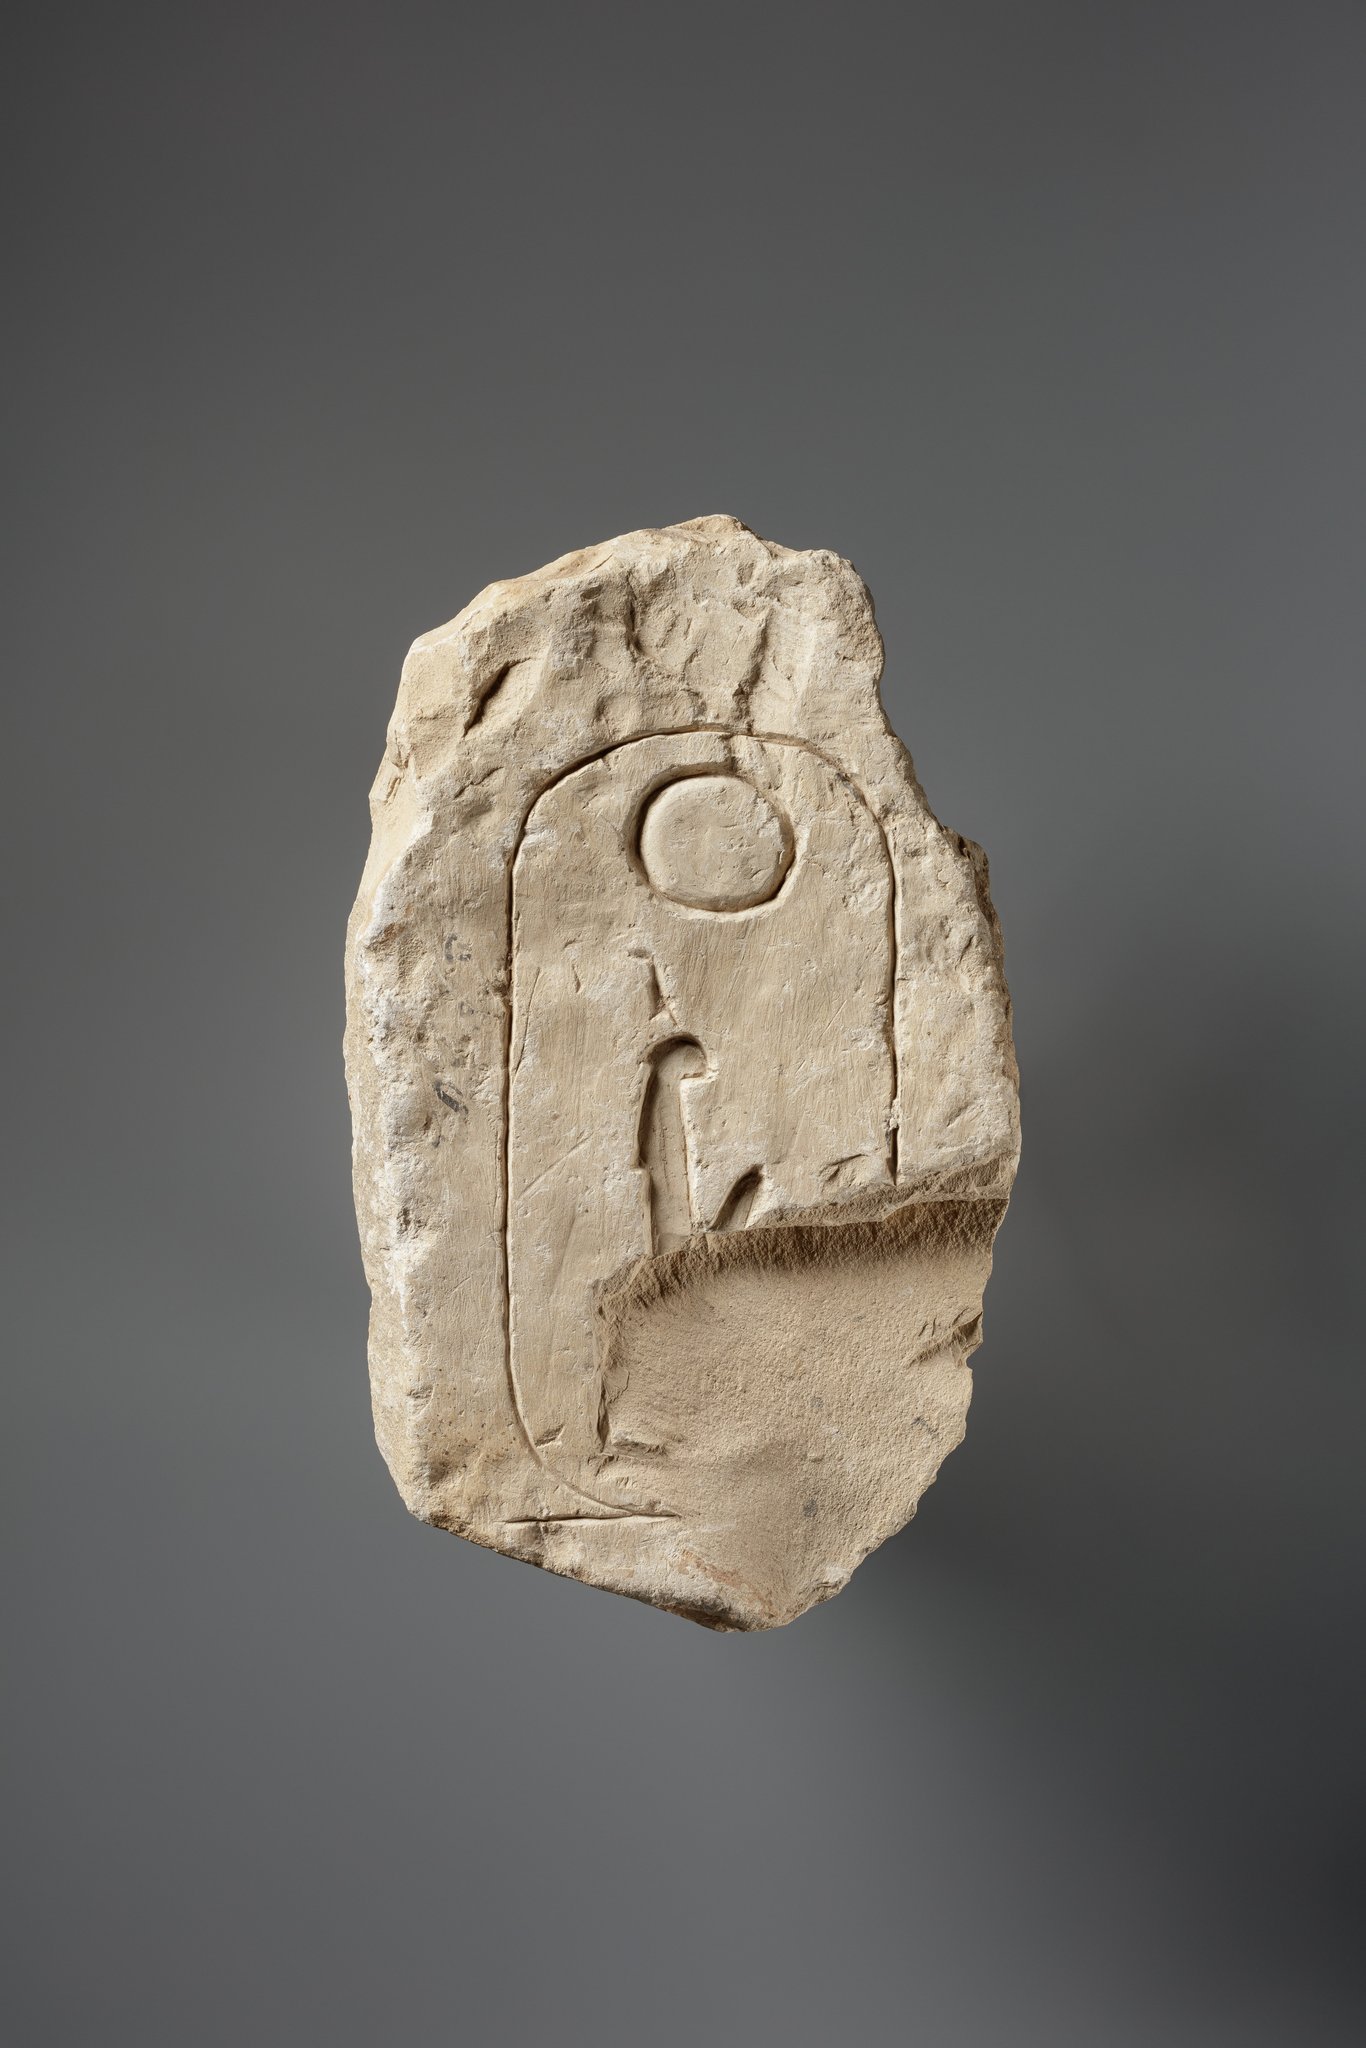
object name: inscribed stone, hatshepsut, maatkare, hieratic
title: Inscribed Stone from Hatshepsut's Valley Temple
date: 1479-1458 BCE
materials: ink, limestone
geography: egypt